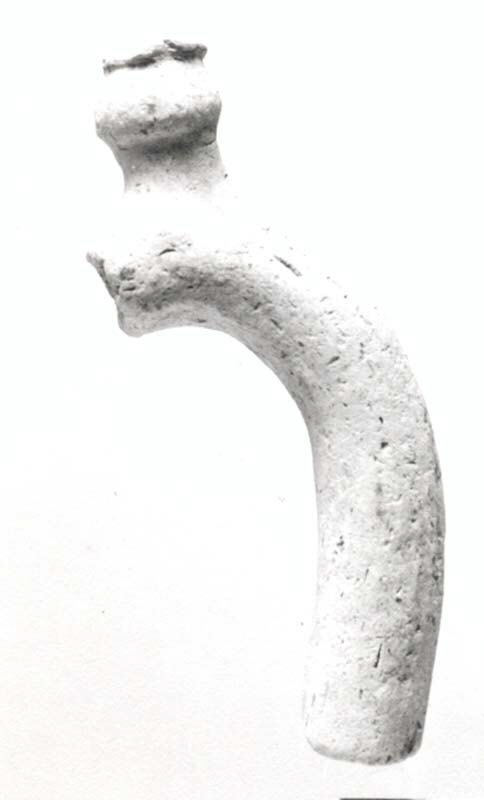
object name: handle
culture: sasanian or islamic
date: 501-800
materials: ceramic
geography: mesopotamia